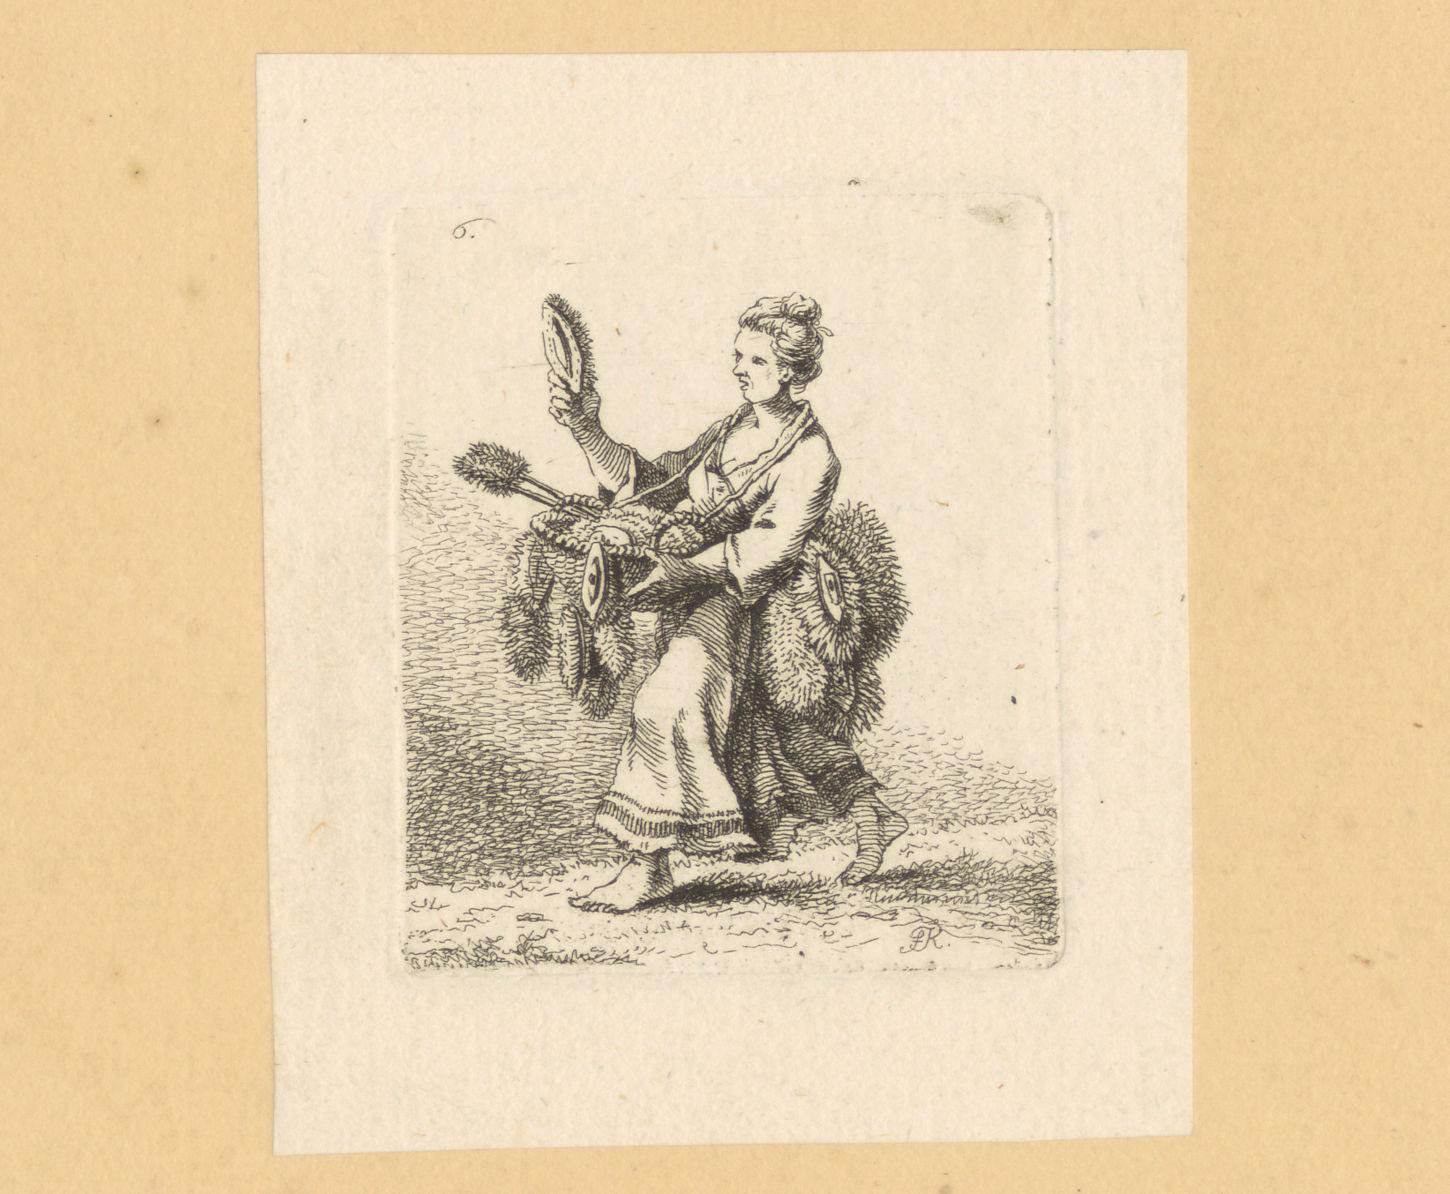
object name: print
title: Etudes D'Apres Nature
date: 1770-1780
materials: paper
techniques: etching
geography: paris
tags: comb, brush and other tools (care of the hair), container made of plant material other than wood: basket, merchant, salesman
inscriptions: number: ‘6’, collector's mark: Lugt 2228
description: Deze prent hoort bij een serie van vijf prenten getiteld 'Etudes d'apres nature' door Ferdinand Kobell gemaakt tussen 1770 en 1775 en zijn uitgegeven in Frankrijk door Gottlieb Hess.